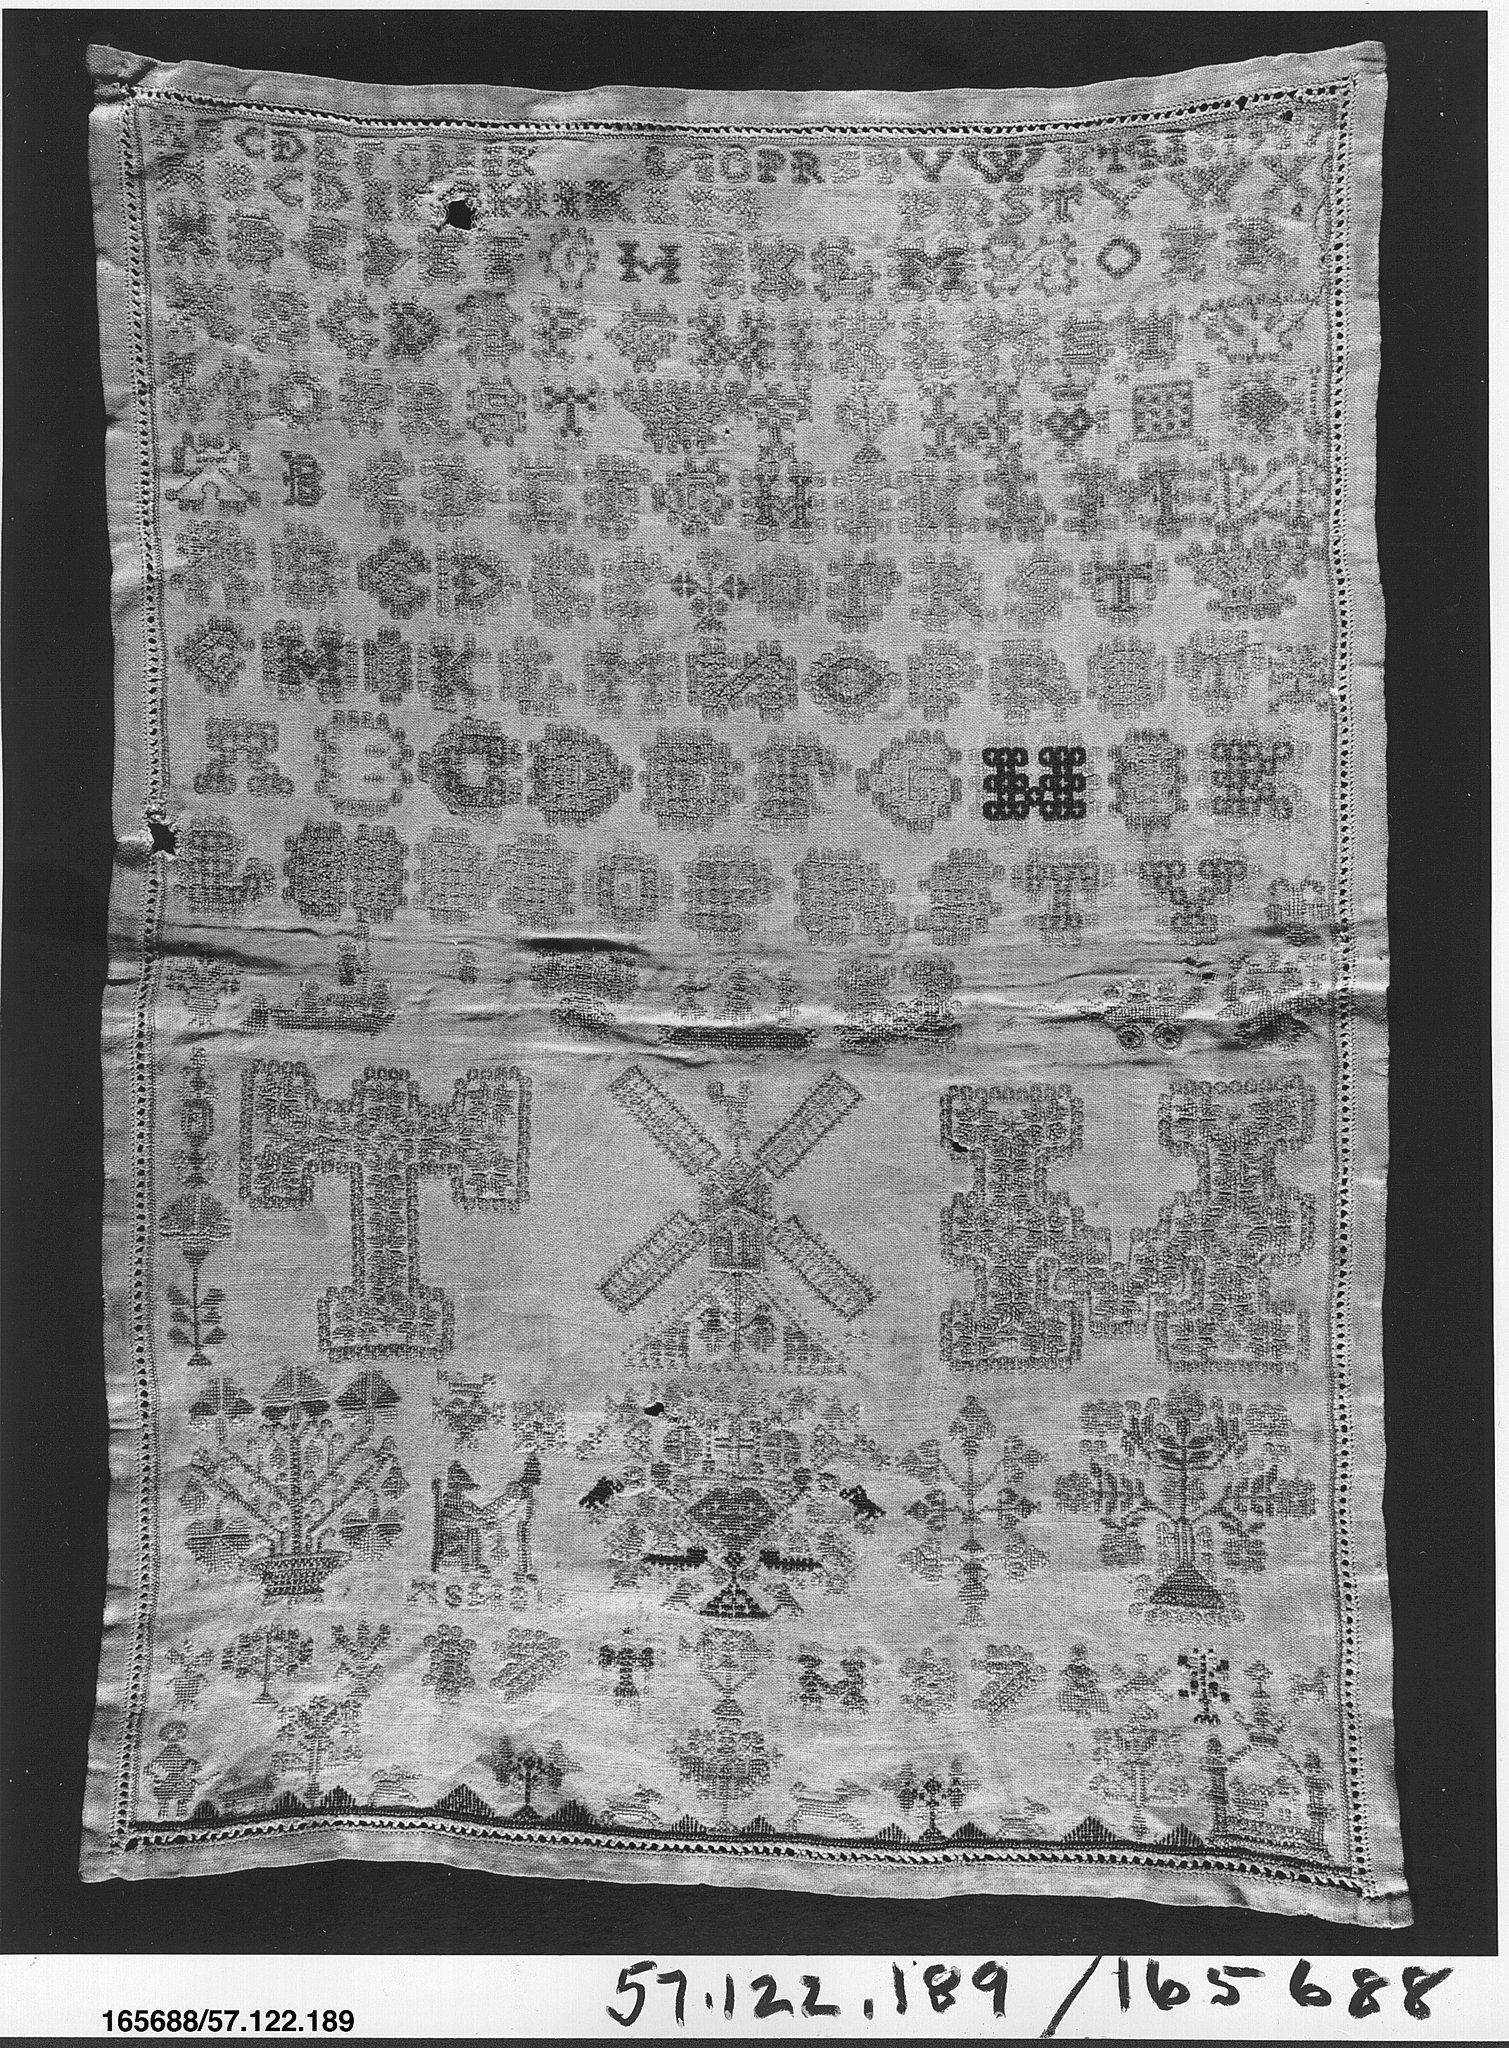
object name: sampler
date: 1736-1737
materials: linen, silk